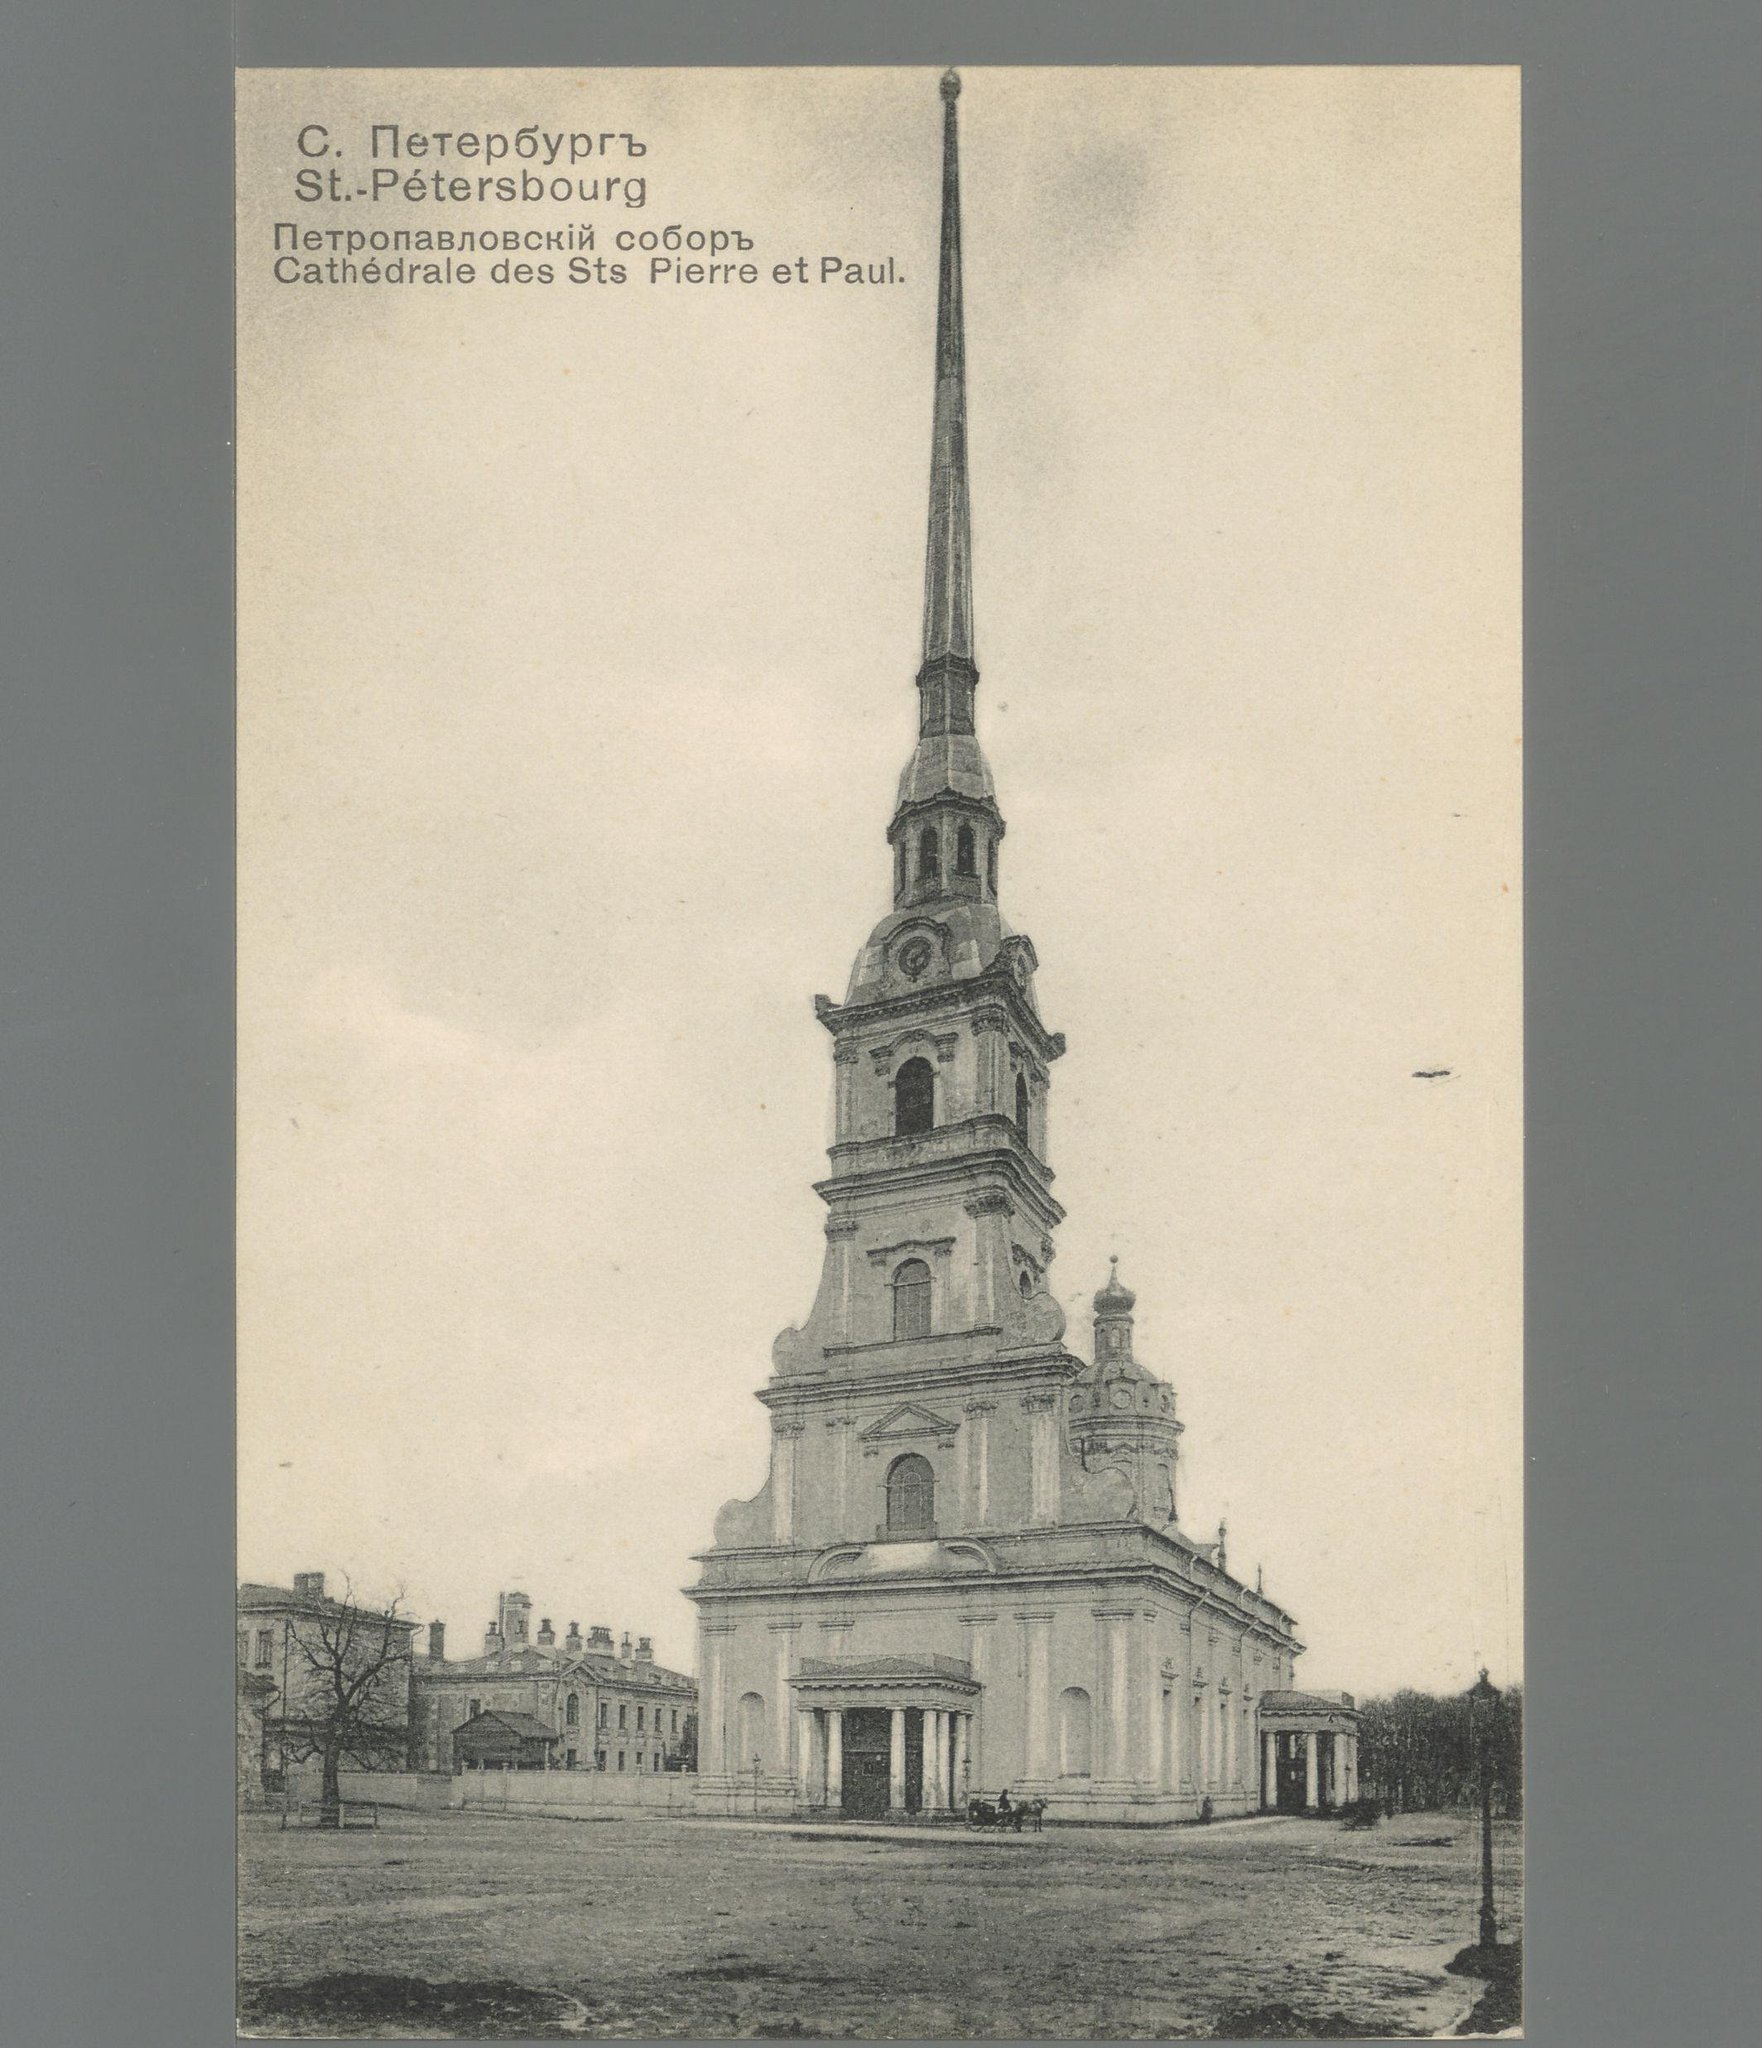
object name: photomechanical print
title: St.-Pétersbourg. Cathédrale des Sts Pierre et Paul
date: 1904-1930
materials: cardboard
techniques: photograph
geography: sint-petersburg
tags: church (exterior)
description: Boven de Franse titel staat de titel in het Russisch.